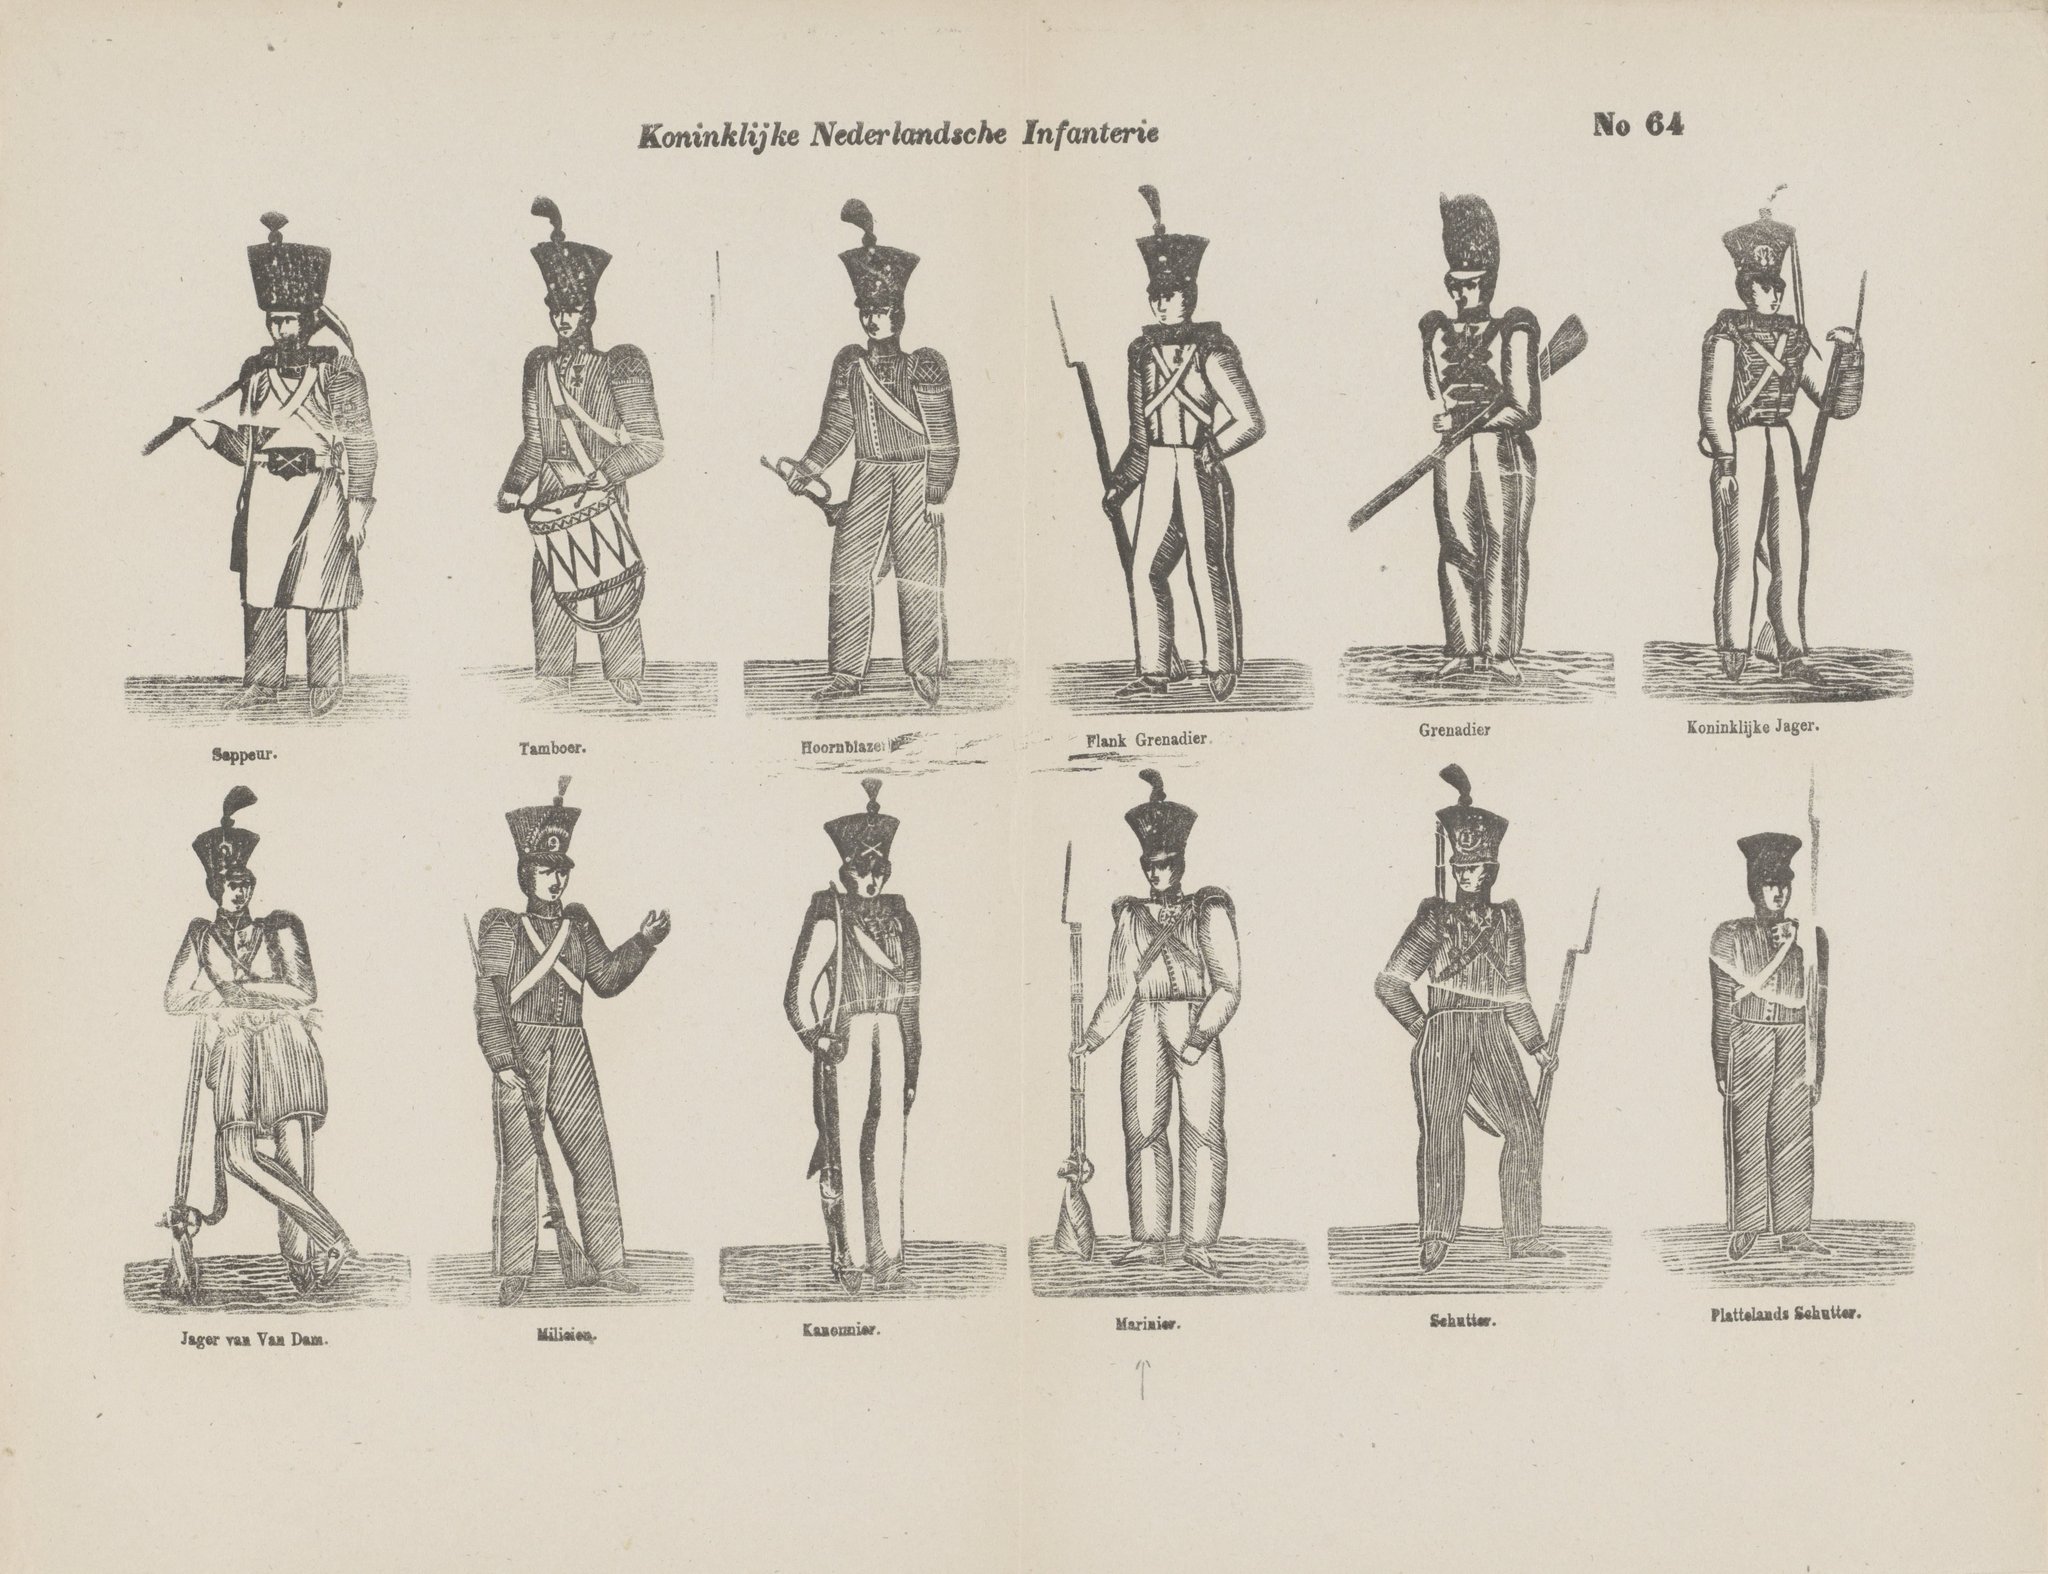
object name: print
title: Koninklijke Nederlandsche infanterie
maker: Anonymous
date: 1848-1881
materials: paper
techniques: letterpress printing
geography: den bosch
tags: the soldier; the soldier's life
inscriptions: collector's mark: Lugt 2760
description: Blad met 12 voorstellingen van militairen. Onder elke afbeelding een onderschrift. Genummerd rechtsboven: No 64.